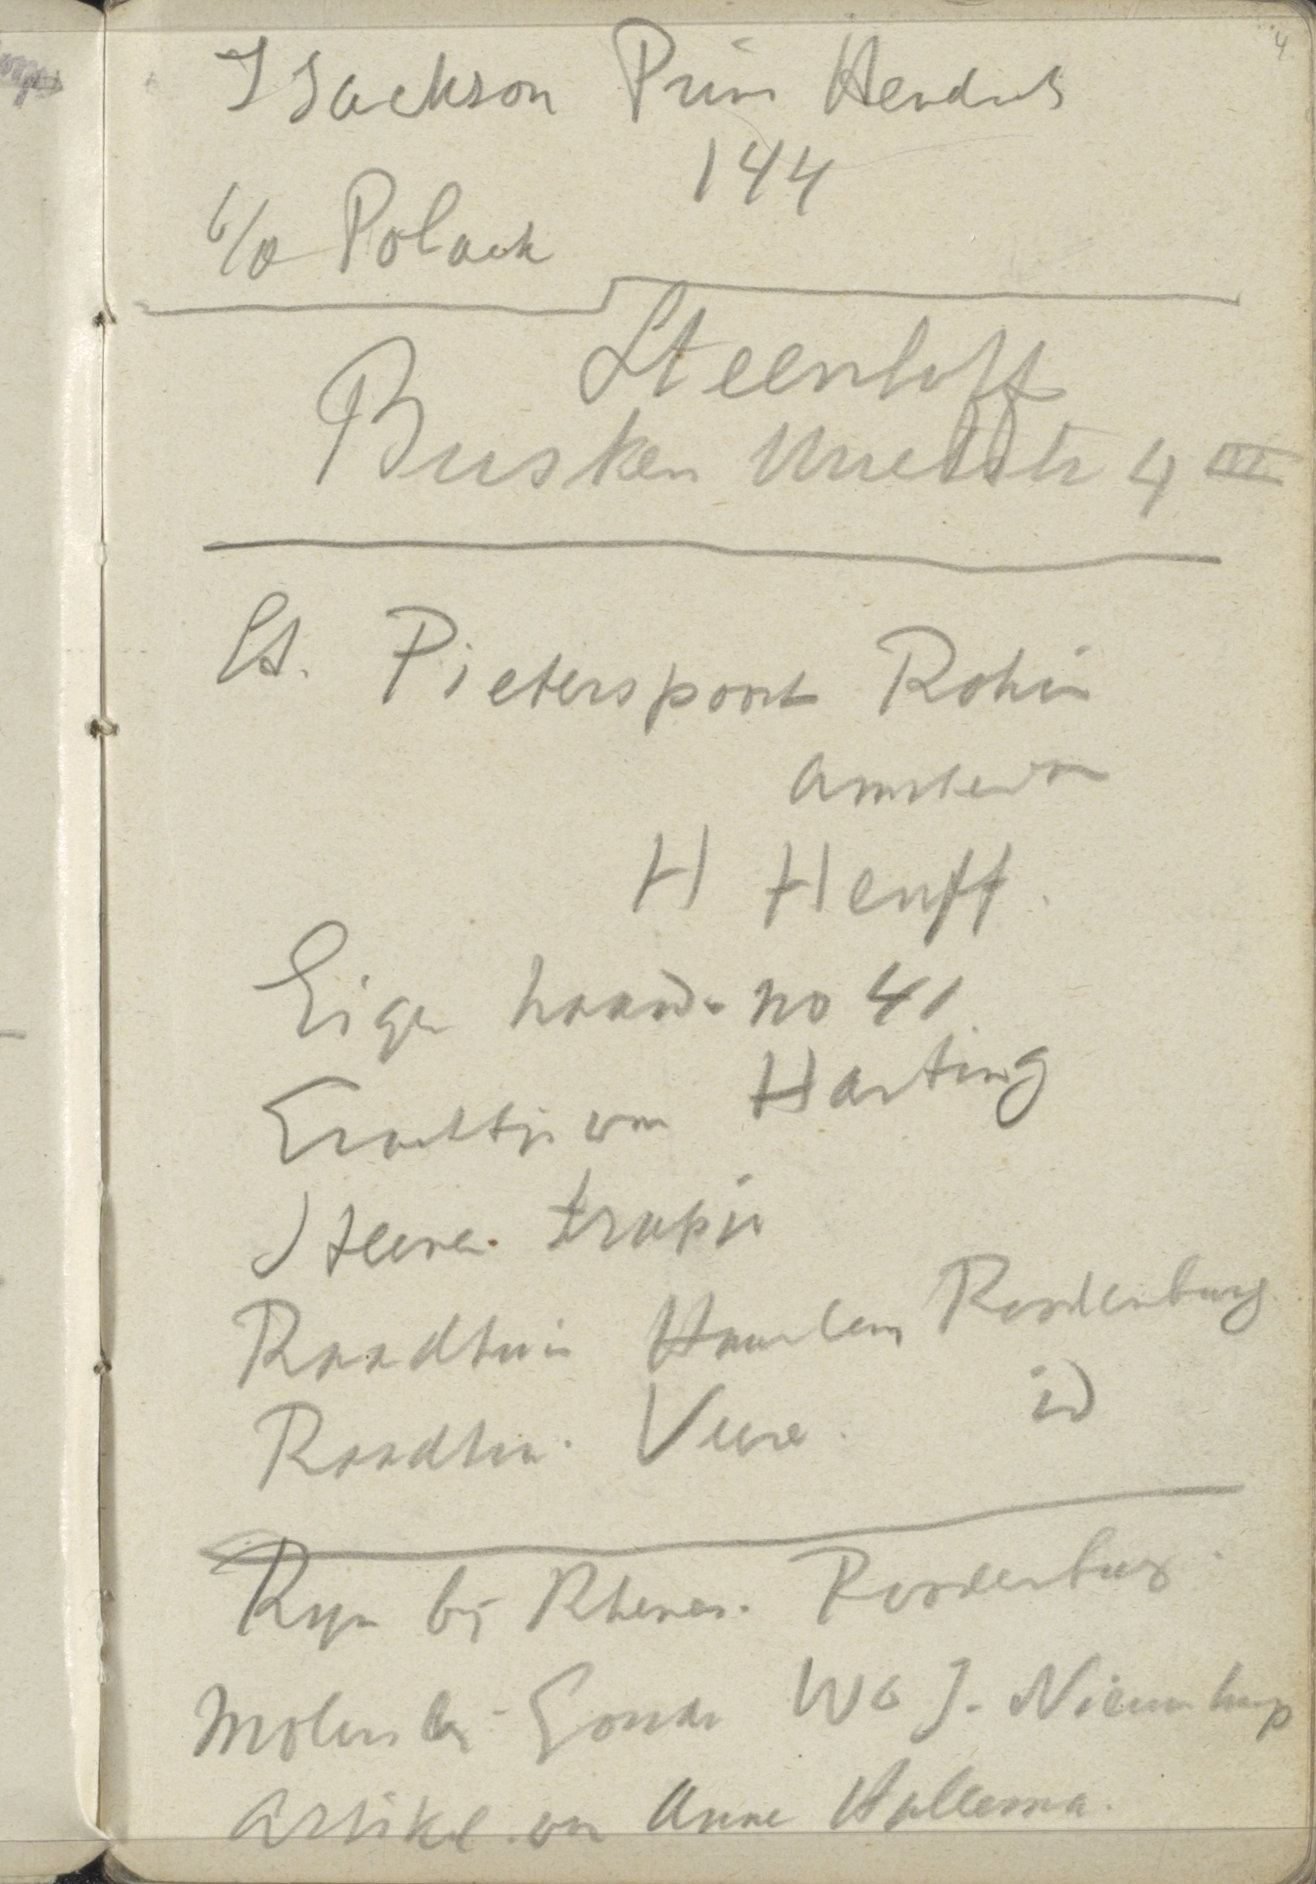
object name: sketchbook leaf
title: Annotaties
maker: george hendrik breitner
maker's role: draughtsman, painter, print maker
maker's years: 1857-1923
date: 1915-1916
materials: paper, pencil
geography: amsterdam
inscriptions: annotation: ‘J. Jackson Prins Hendrik/ 144/ b/d Polack/ Steenhoff[?]/ Busken Huetstr 4 III/ St. Pieterspoort Rokin/ Amsterdam/ H Henff[?]/ Eigen Haard no. 41/ Grachtje van[?] Harting/ Steenen trapje/ Raadhuis Haarlem Roodenburg/ Raadhuis Veere id/ Rijn bij Rhenen. Roosenburg/ Molens bij Gouda Wo[?] J. Nieuw[...]/ Artikel van Anne Hollema[?]’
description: Pagina 4 uit een schetsboek met 43 bladen.